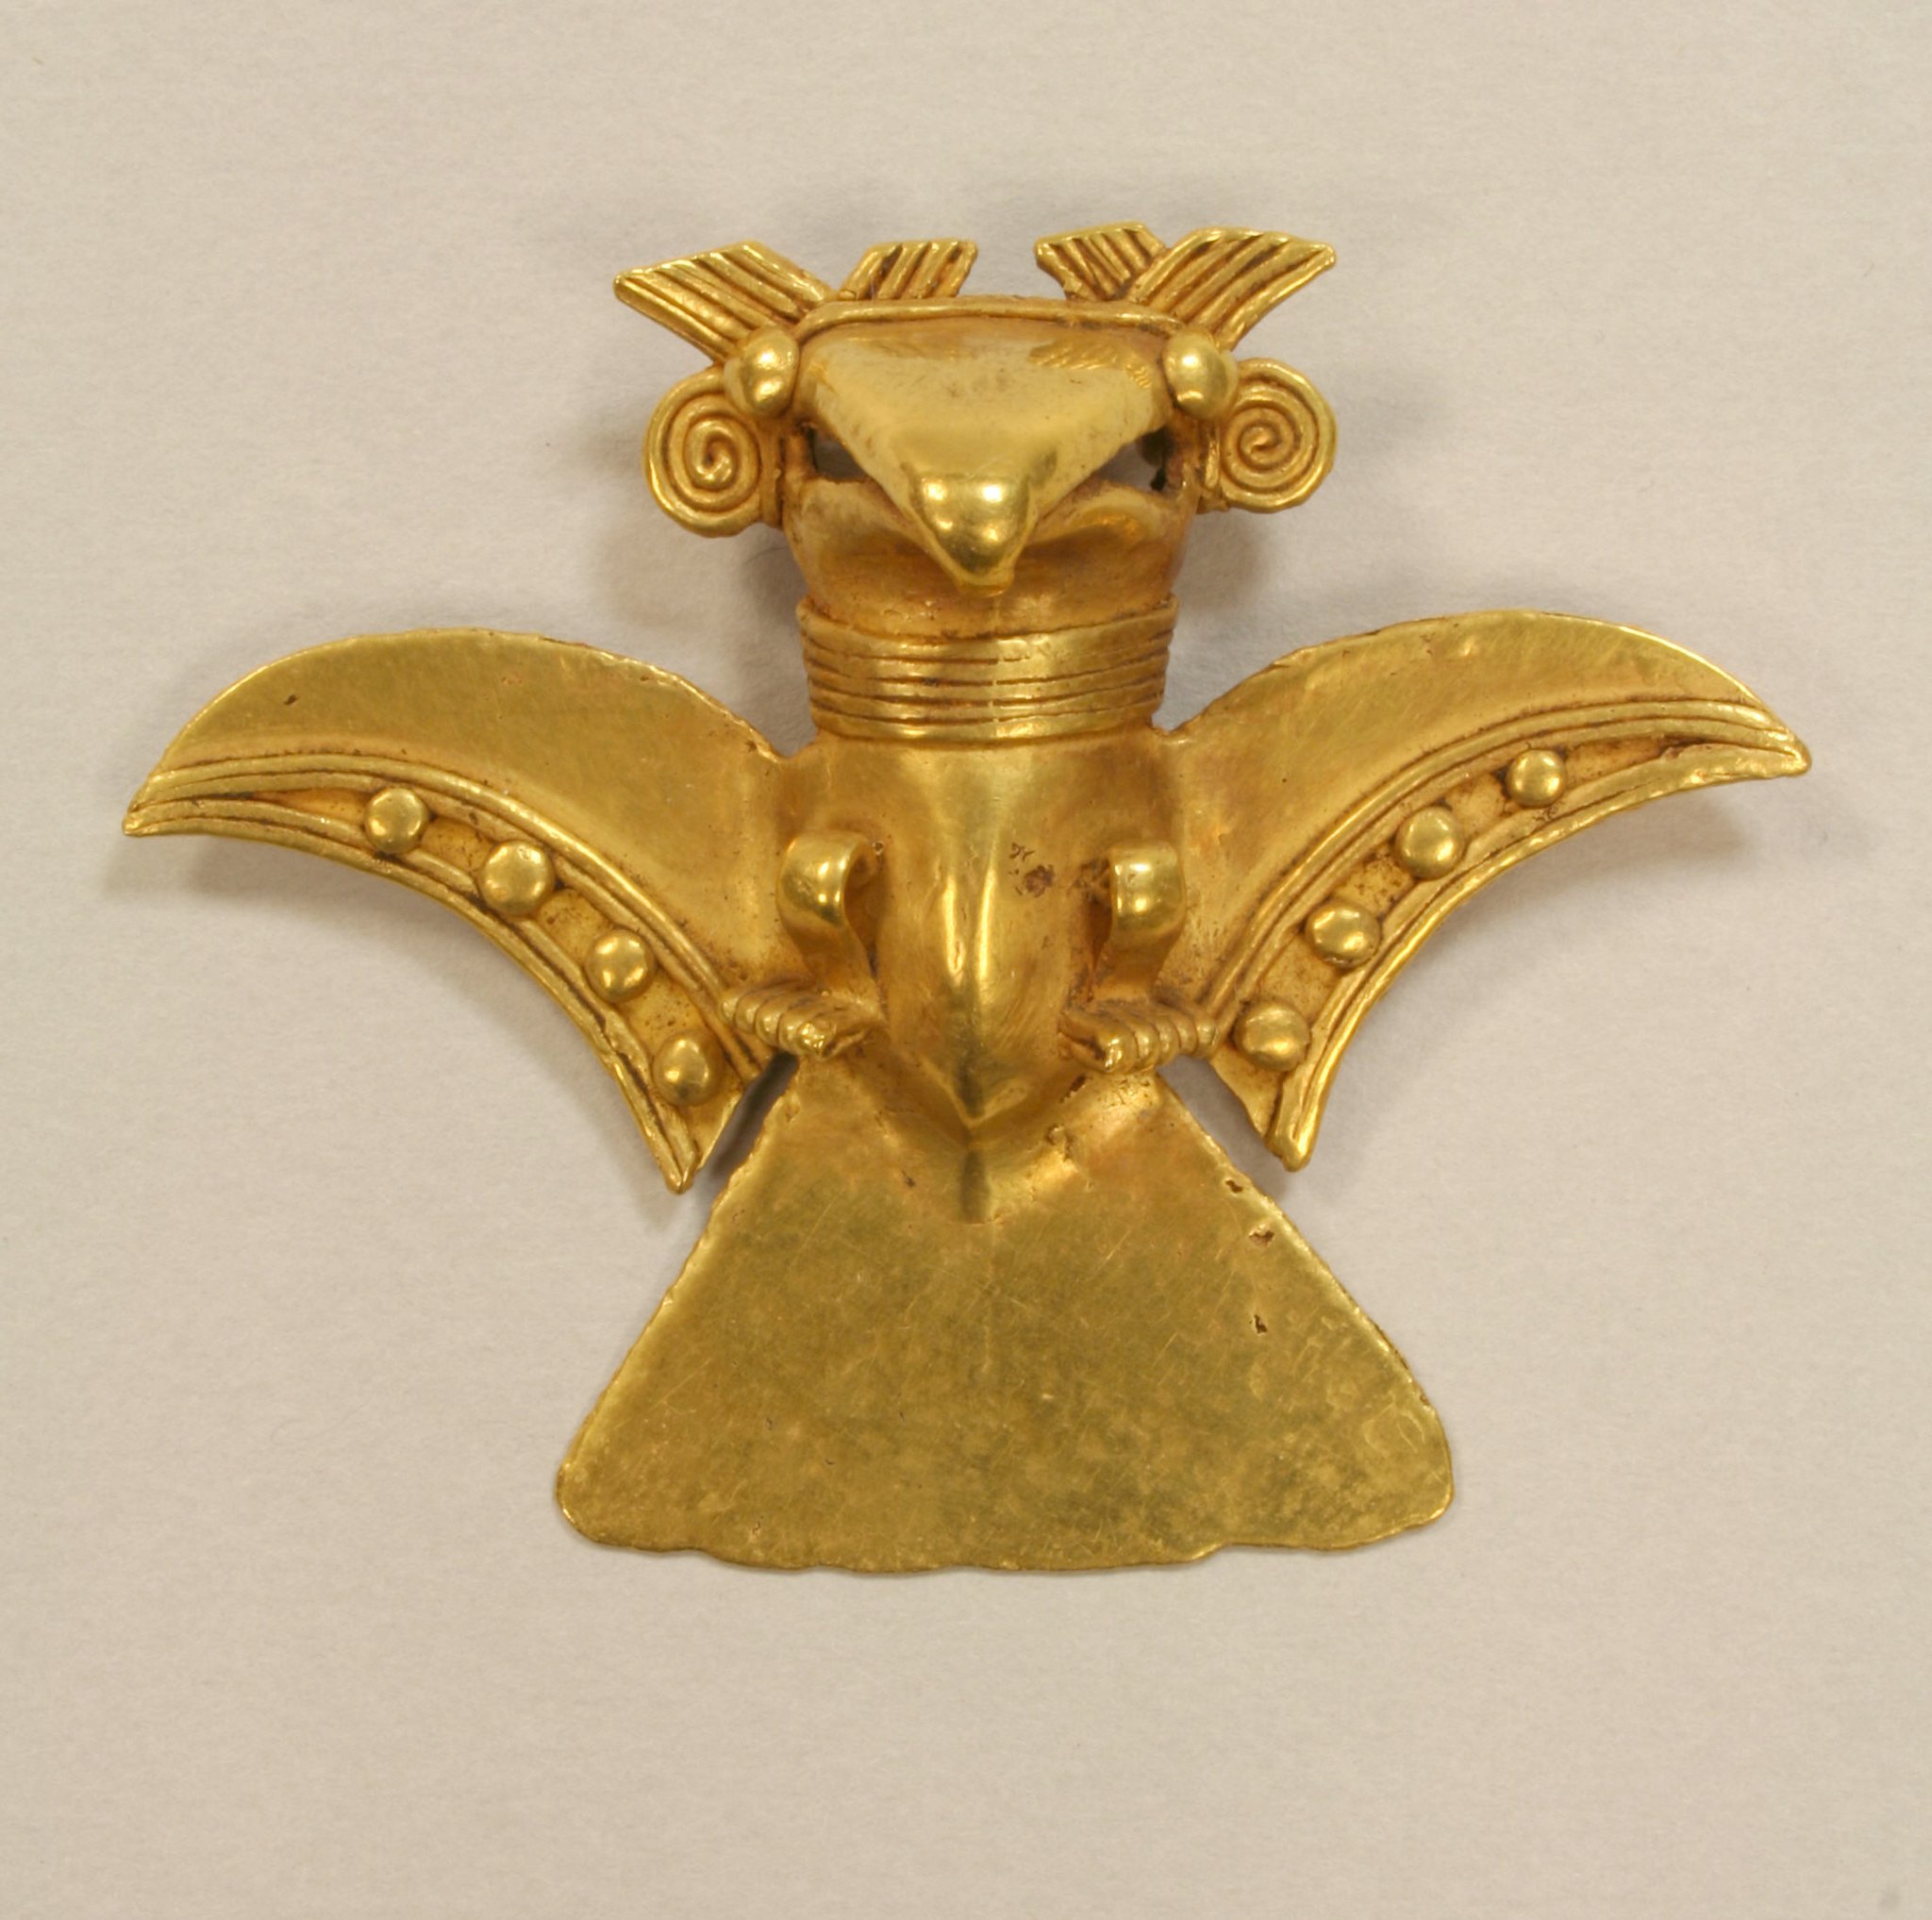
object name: pendant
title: Eagle Pendant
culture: veraguas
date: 1001-1600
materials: gold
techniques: casting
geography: panama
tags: eagles